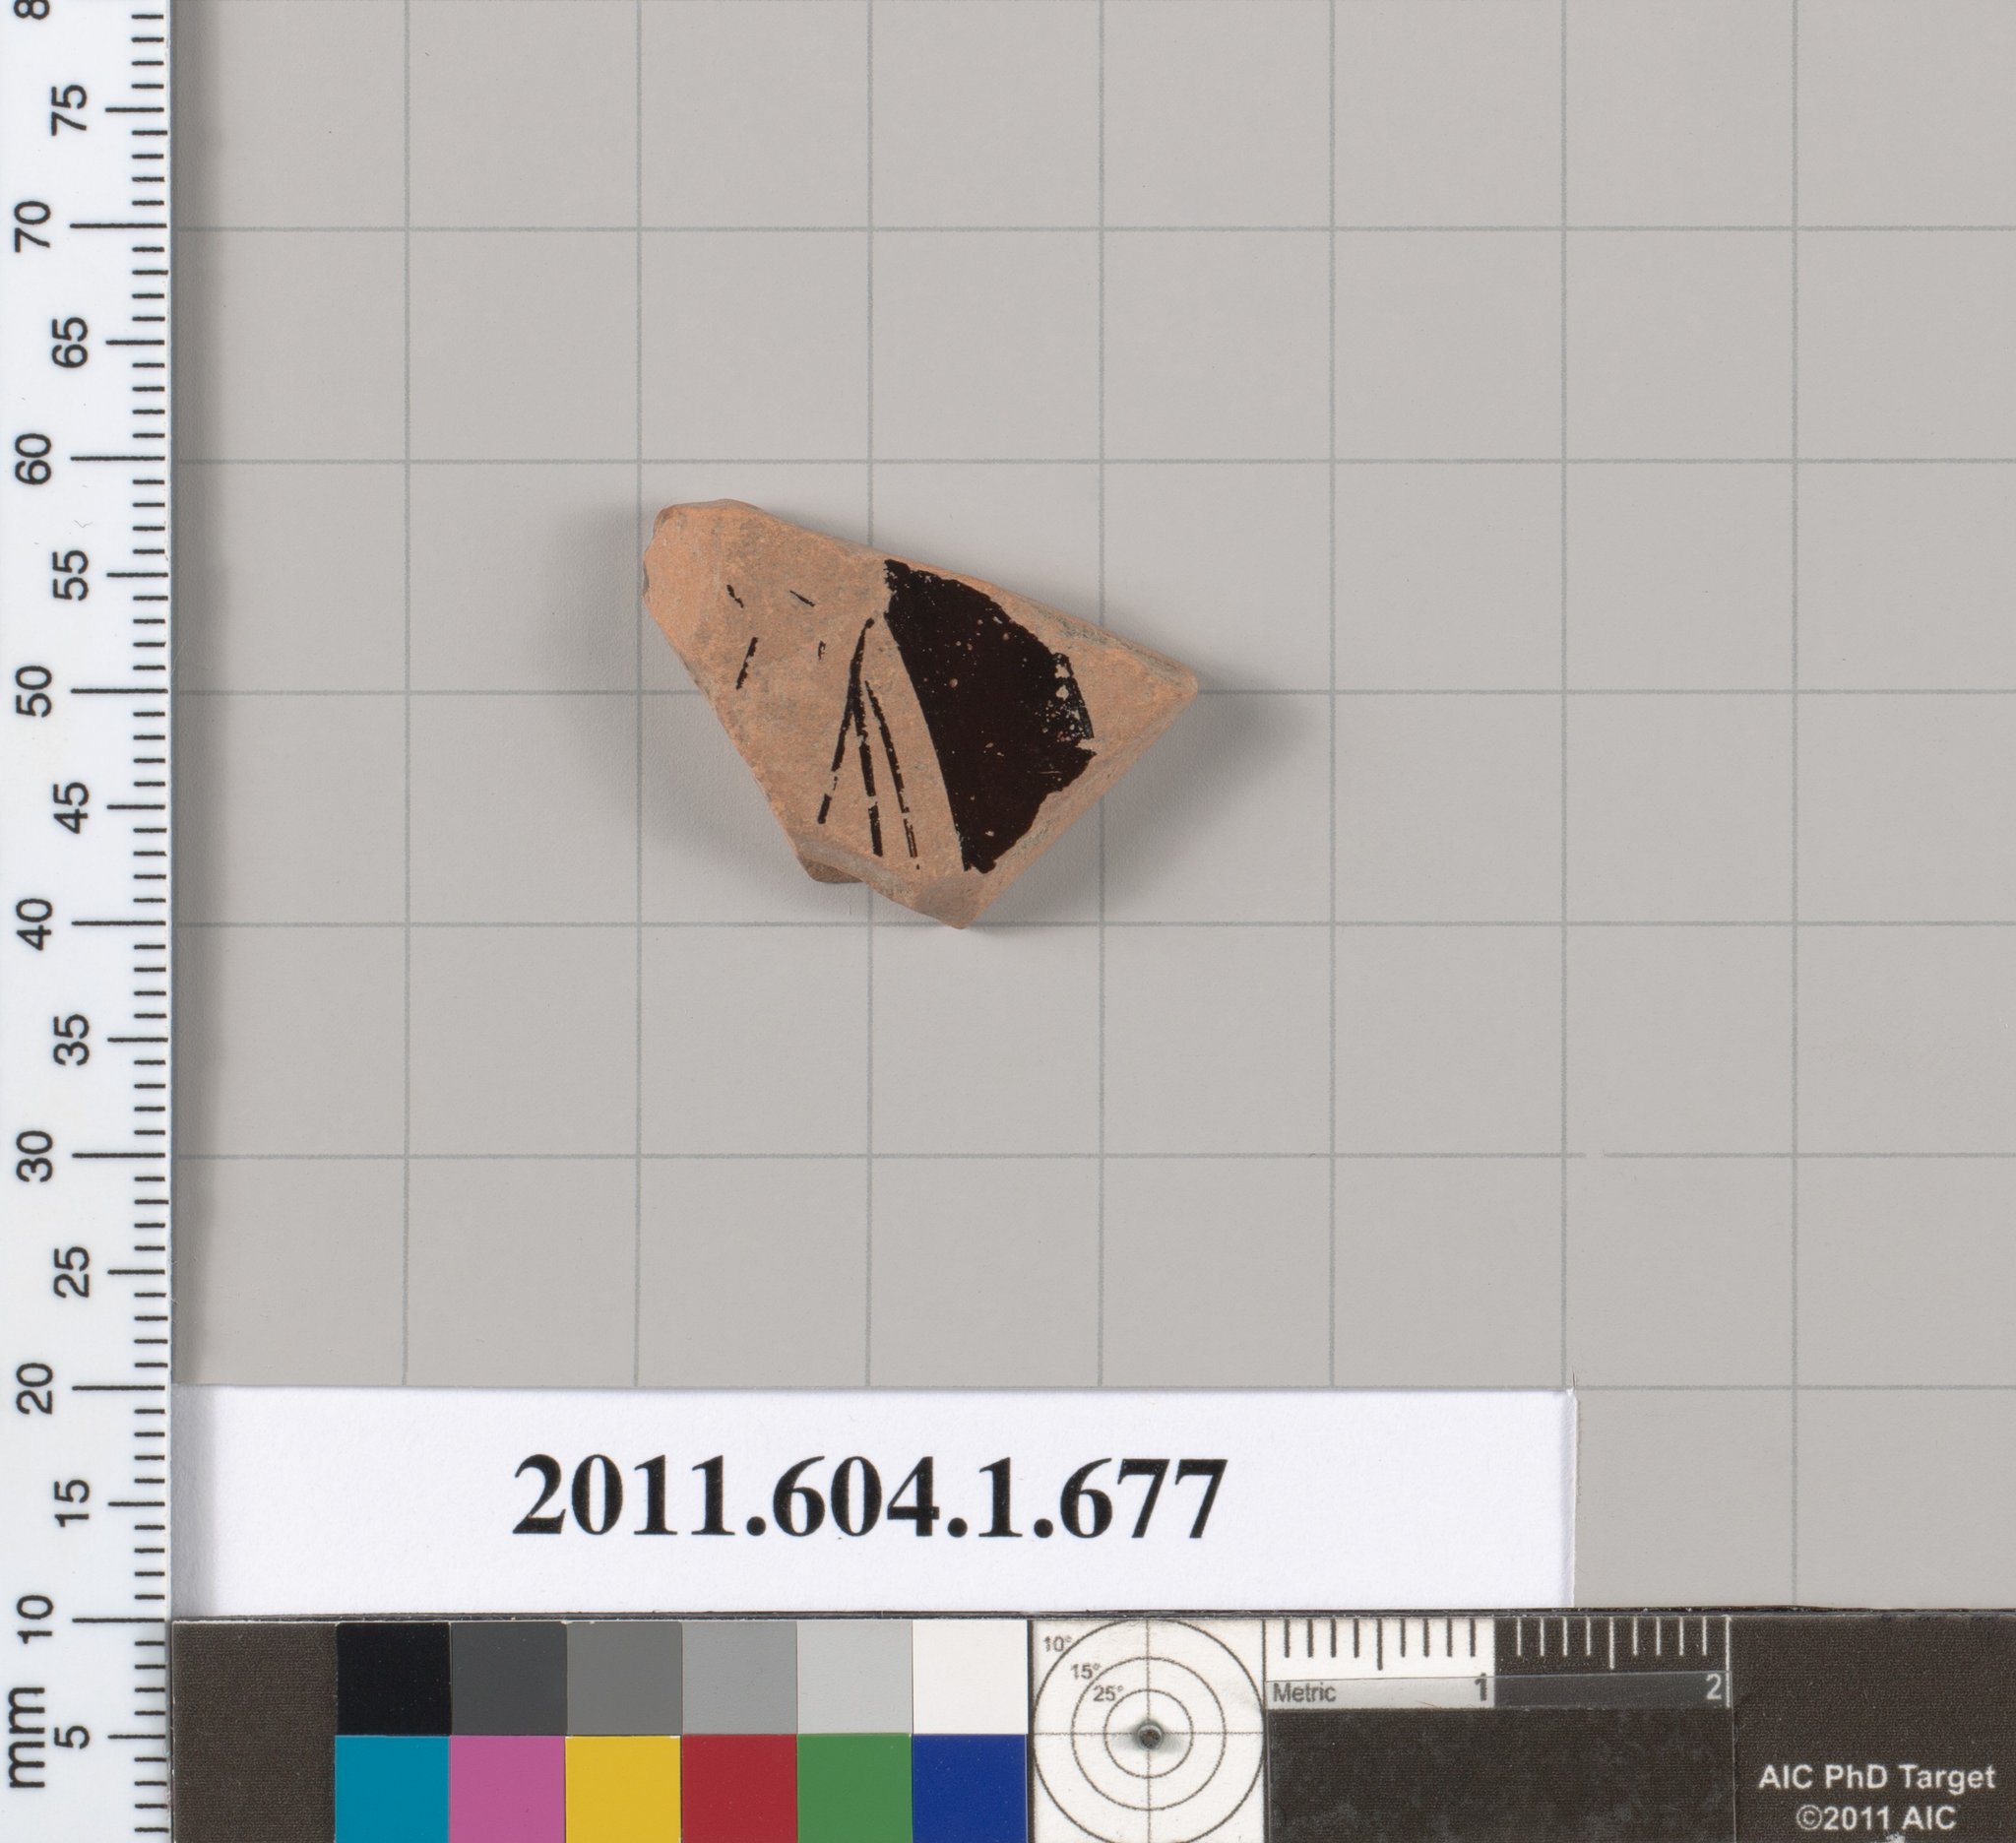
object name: kylix fragment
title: Terracotta fragment of a kylix (drinking cup)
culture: greek, attic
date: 475-451 BCE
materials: terracotta